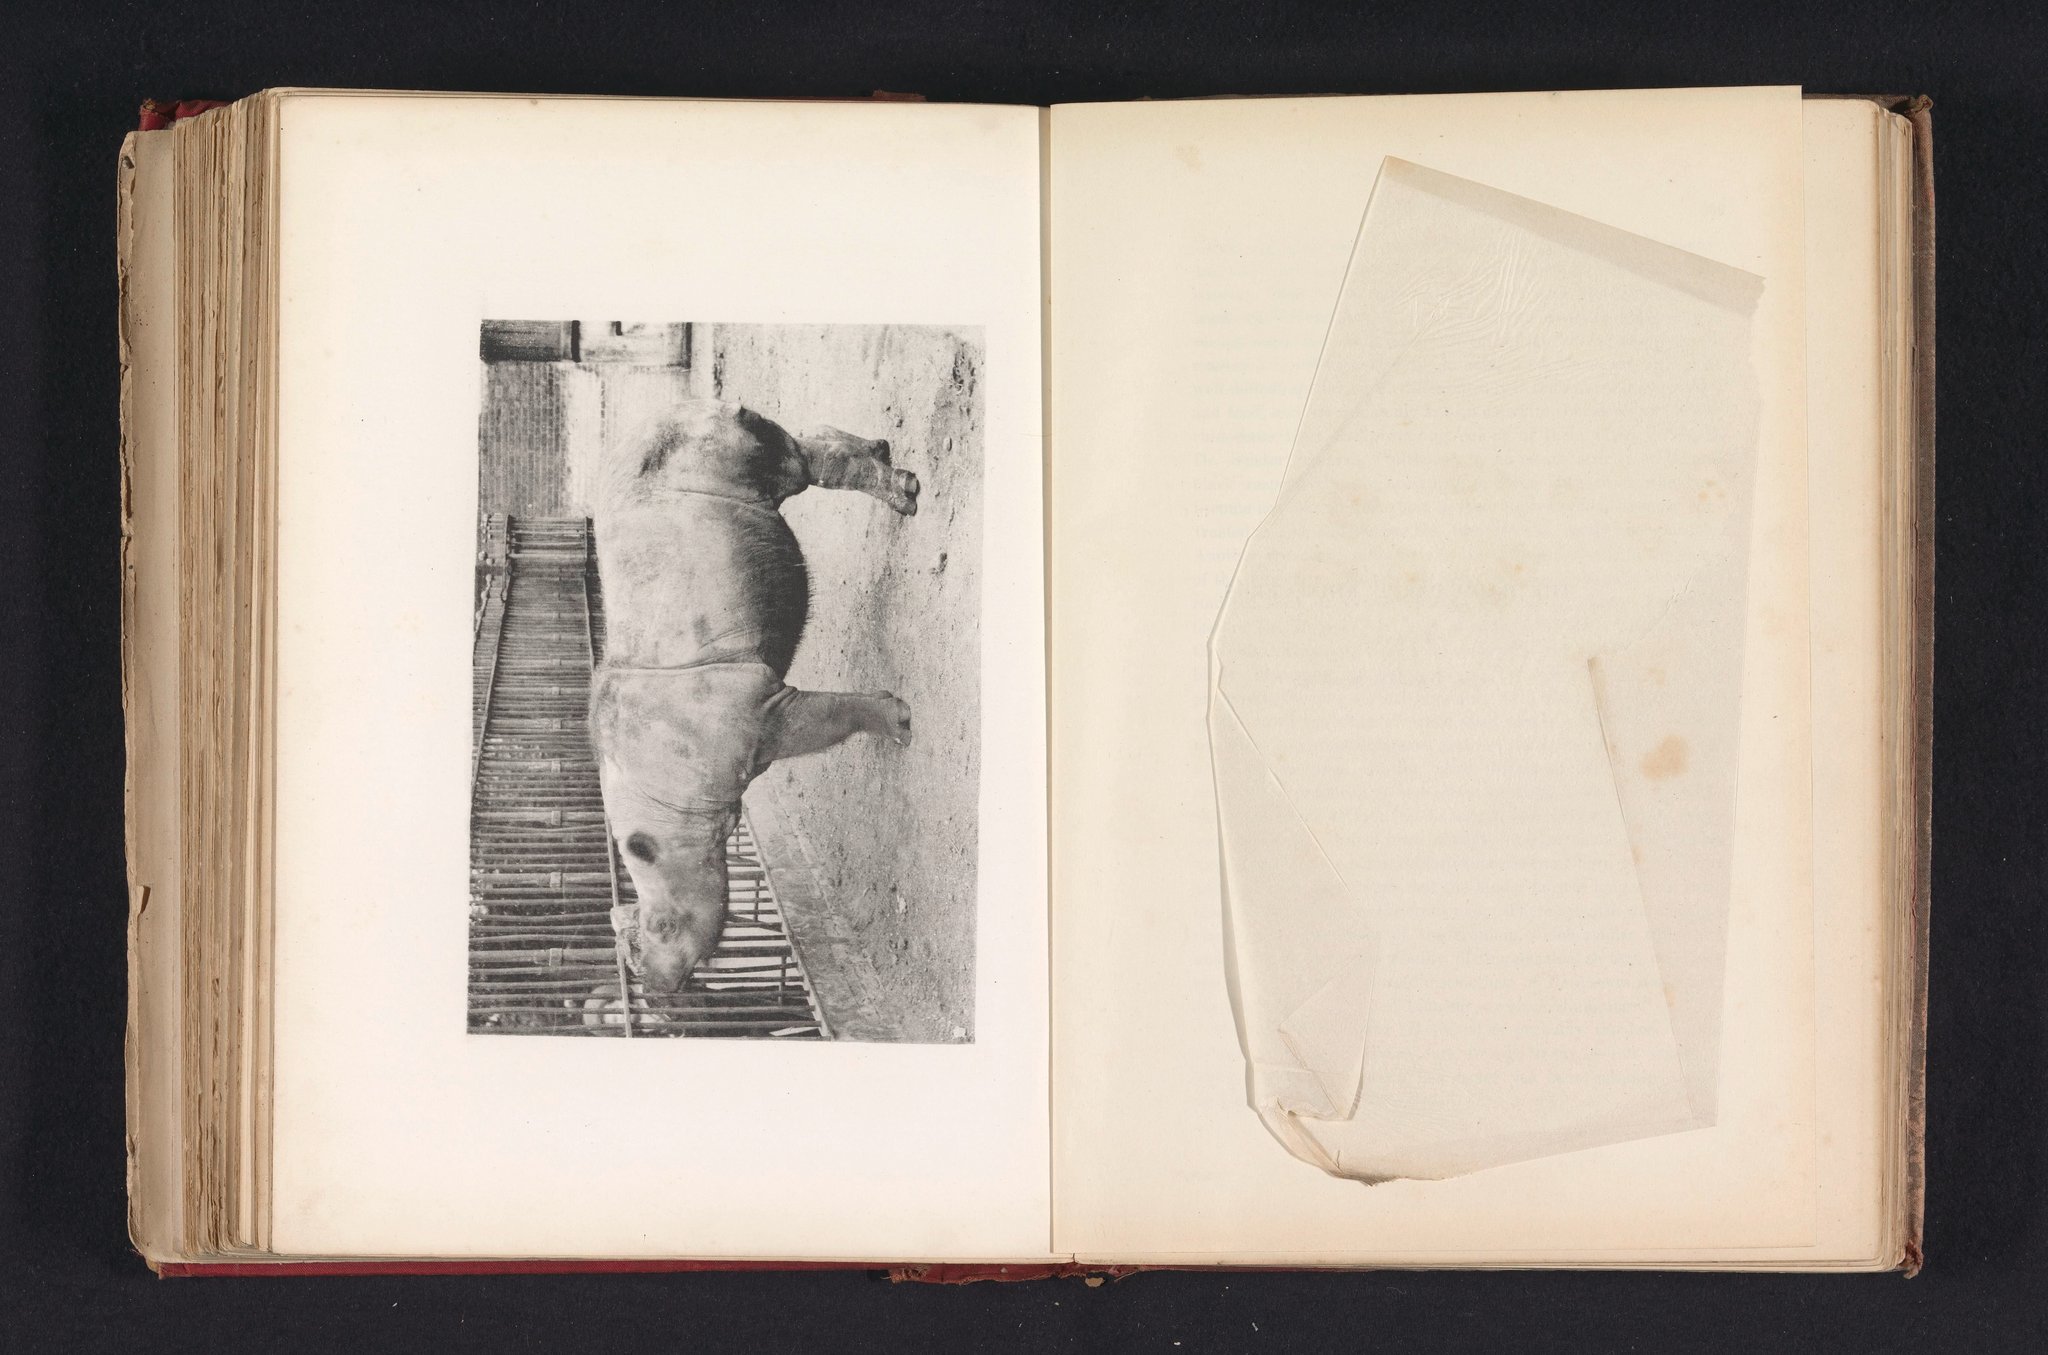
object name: photomechanical print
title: The hairy-eared rhinoceros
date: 1876-1886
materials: paper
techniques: photograph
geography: paris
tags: hoofed animals: rhinoceros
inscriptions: inscription: ‘"Begum", captured in Chittagong.’